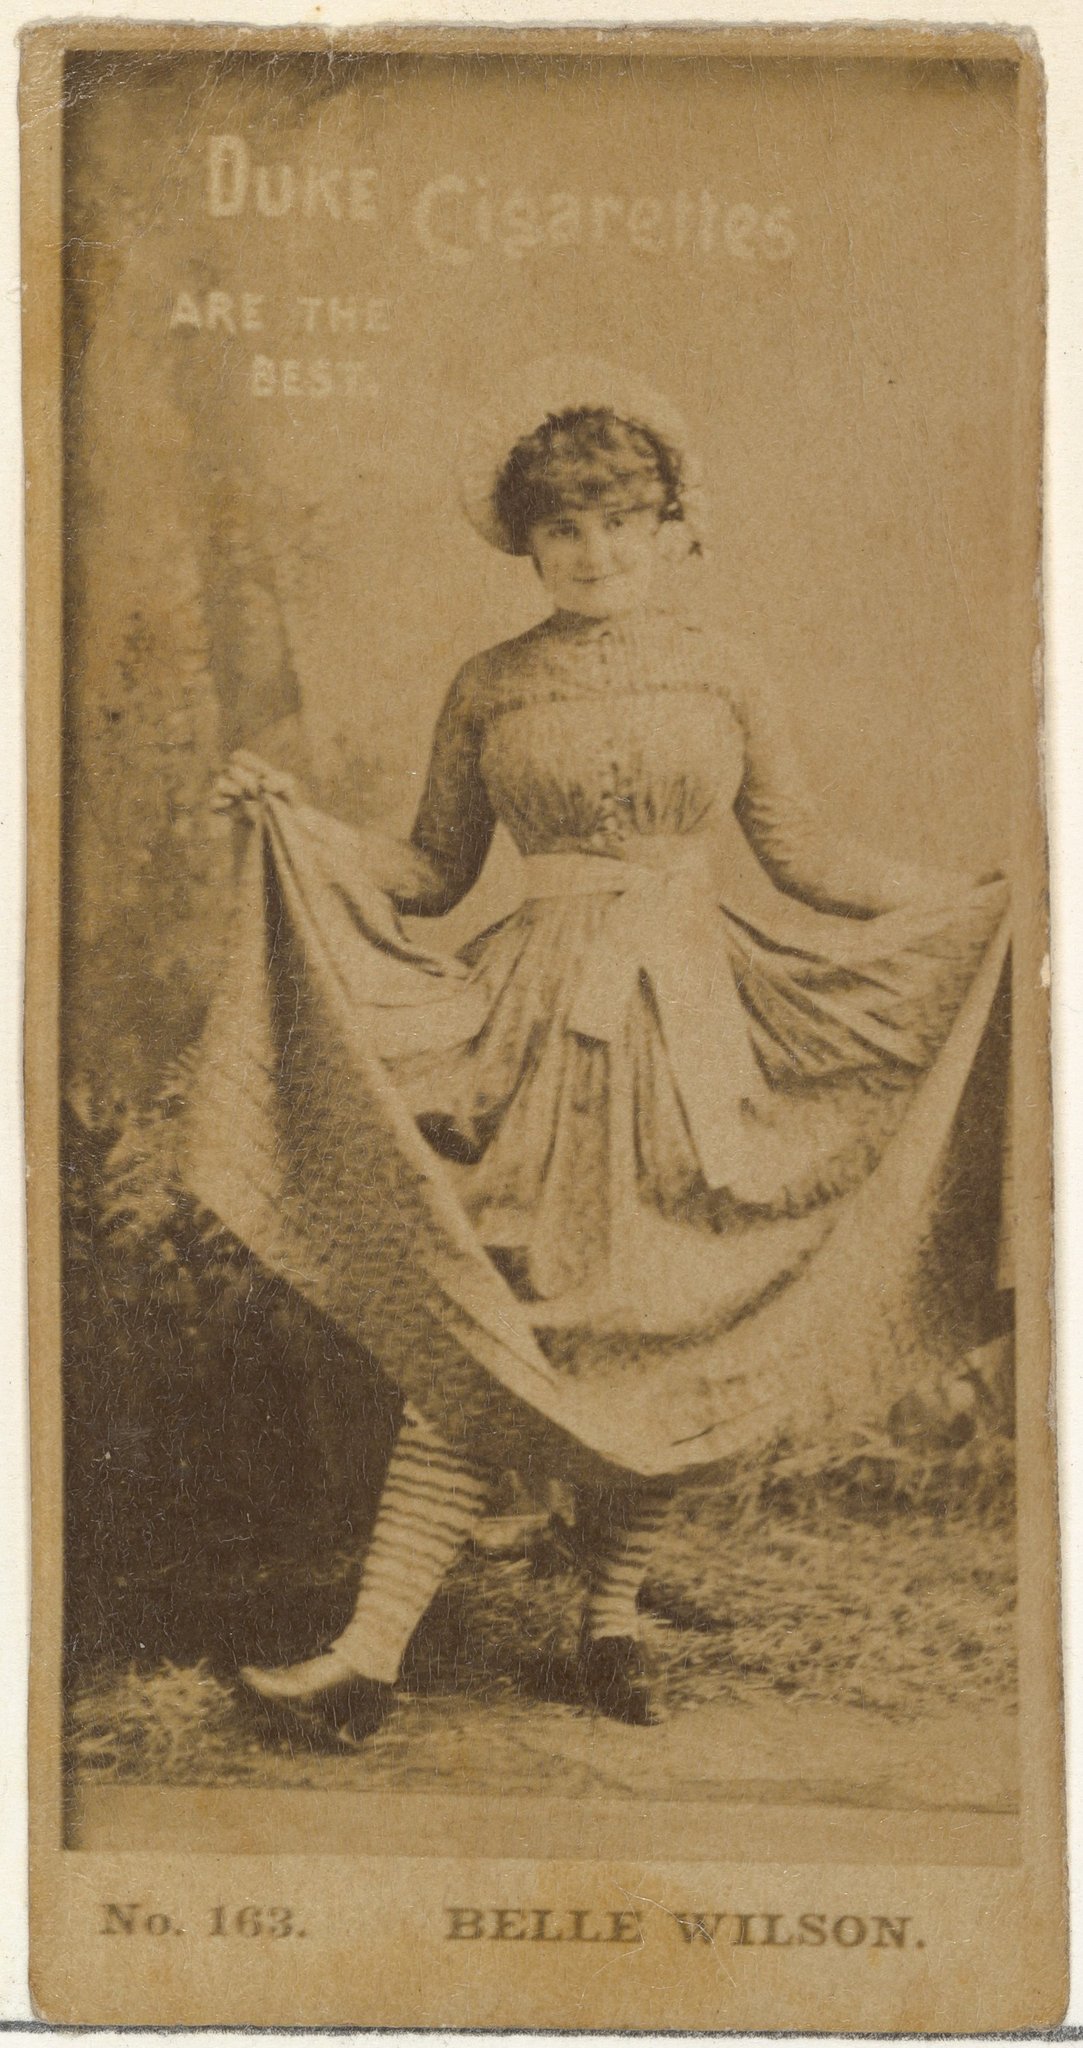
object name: photograph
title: Card Number 163, Belle Wilson, from the Actors and Actresses series (N145-6) issued by Duke Sons & Co. to promote Duke Cigarettes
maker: w. duke, sons & co.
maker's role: publisher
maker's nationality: american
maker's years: 1870-1920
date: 1880-1889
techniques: albumen silver print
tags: portraits,women,actresses